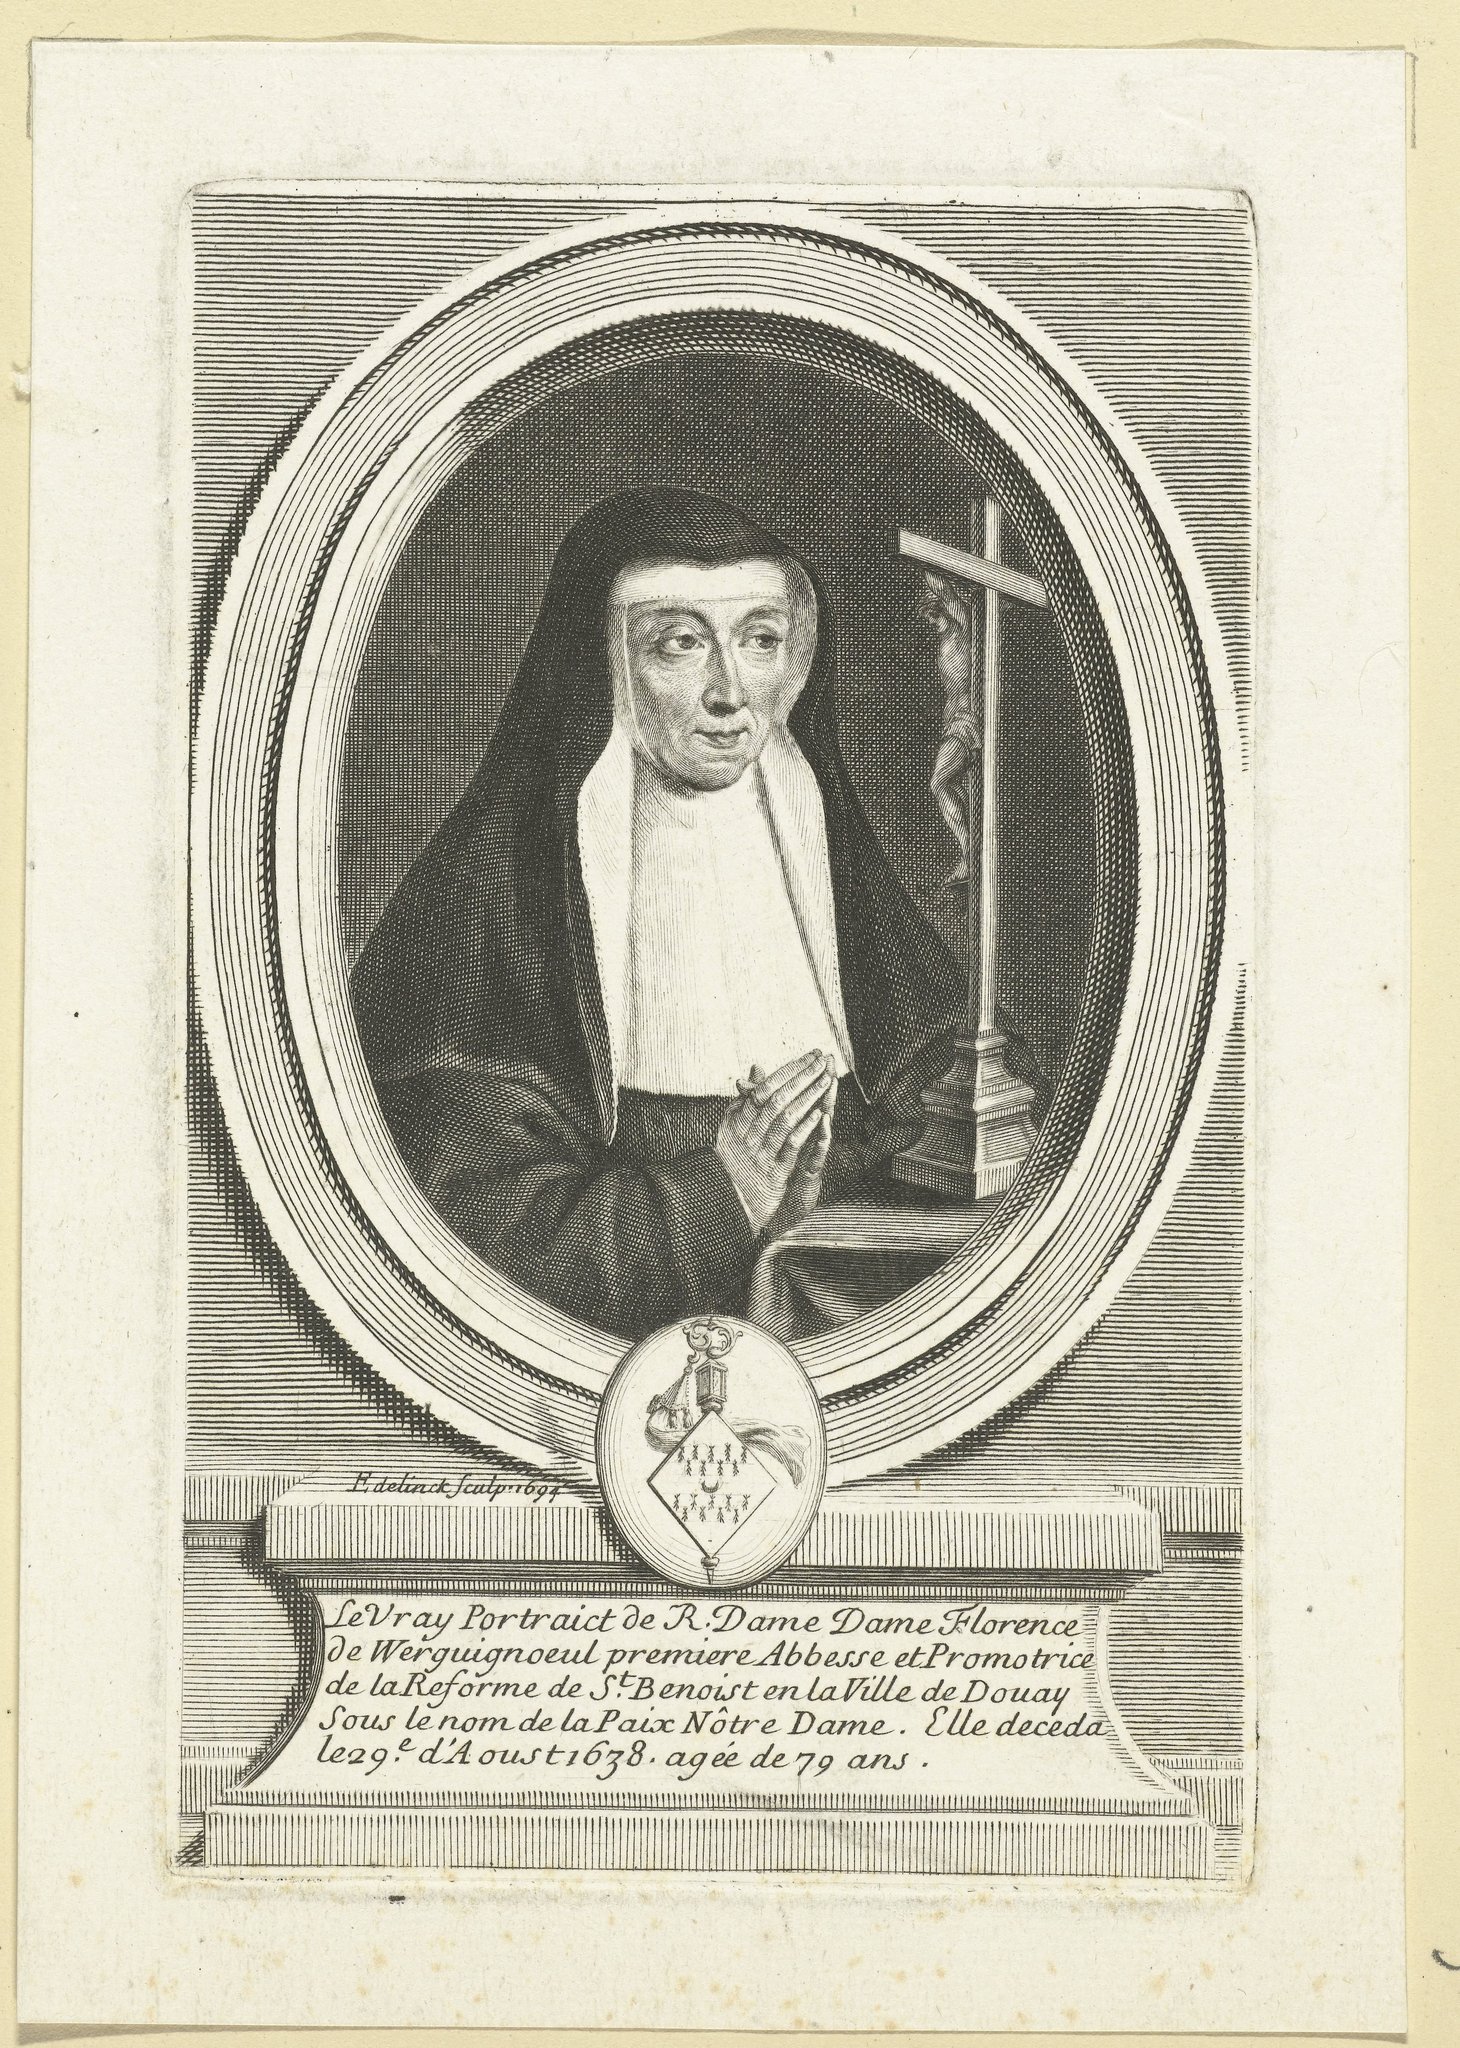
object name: print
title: Portret van Florence de Werguignoeul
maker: gerard edelinck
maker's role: print maker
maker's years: 1640-1707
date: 1694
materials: paper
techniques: engraving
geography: paris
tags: france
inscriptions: collector's mark: Lugt 240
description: Portret van de abdis Florence de Werguignoeul (1559-1638), afgebeeld met gevouwen handen, bij crucifix, in ovale omlijsting met wapen. Onder de lijst een console met een Frans vers van vijf regels.